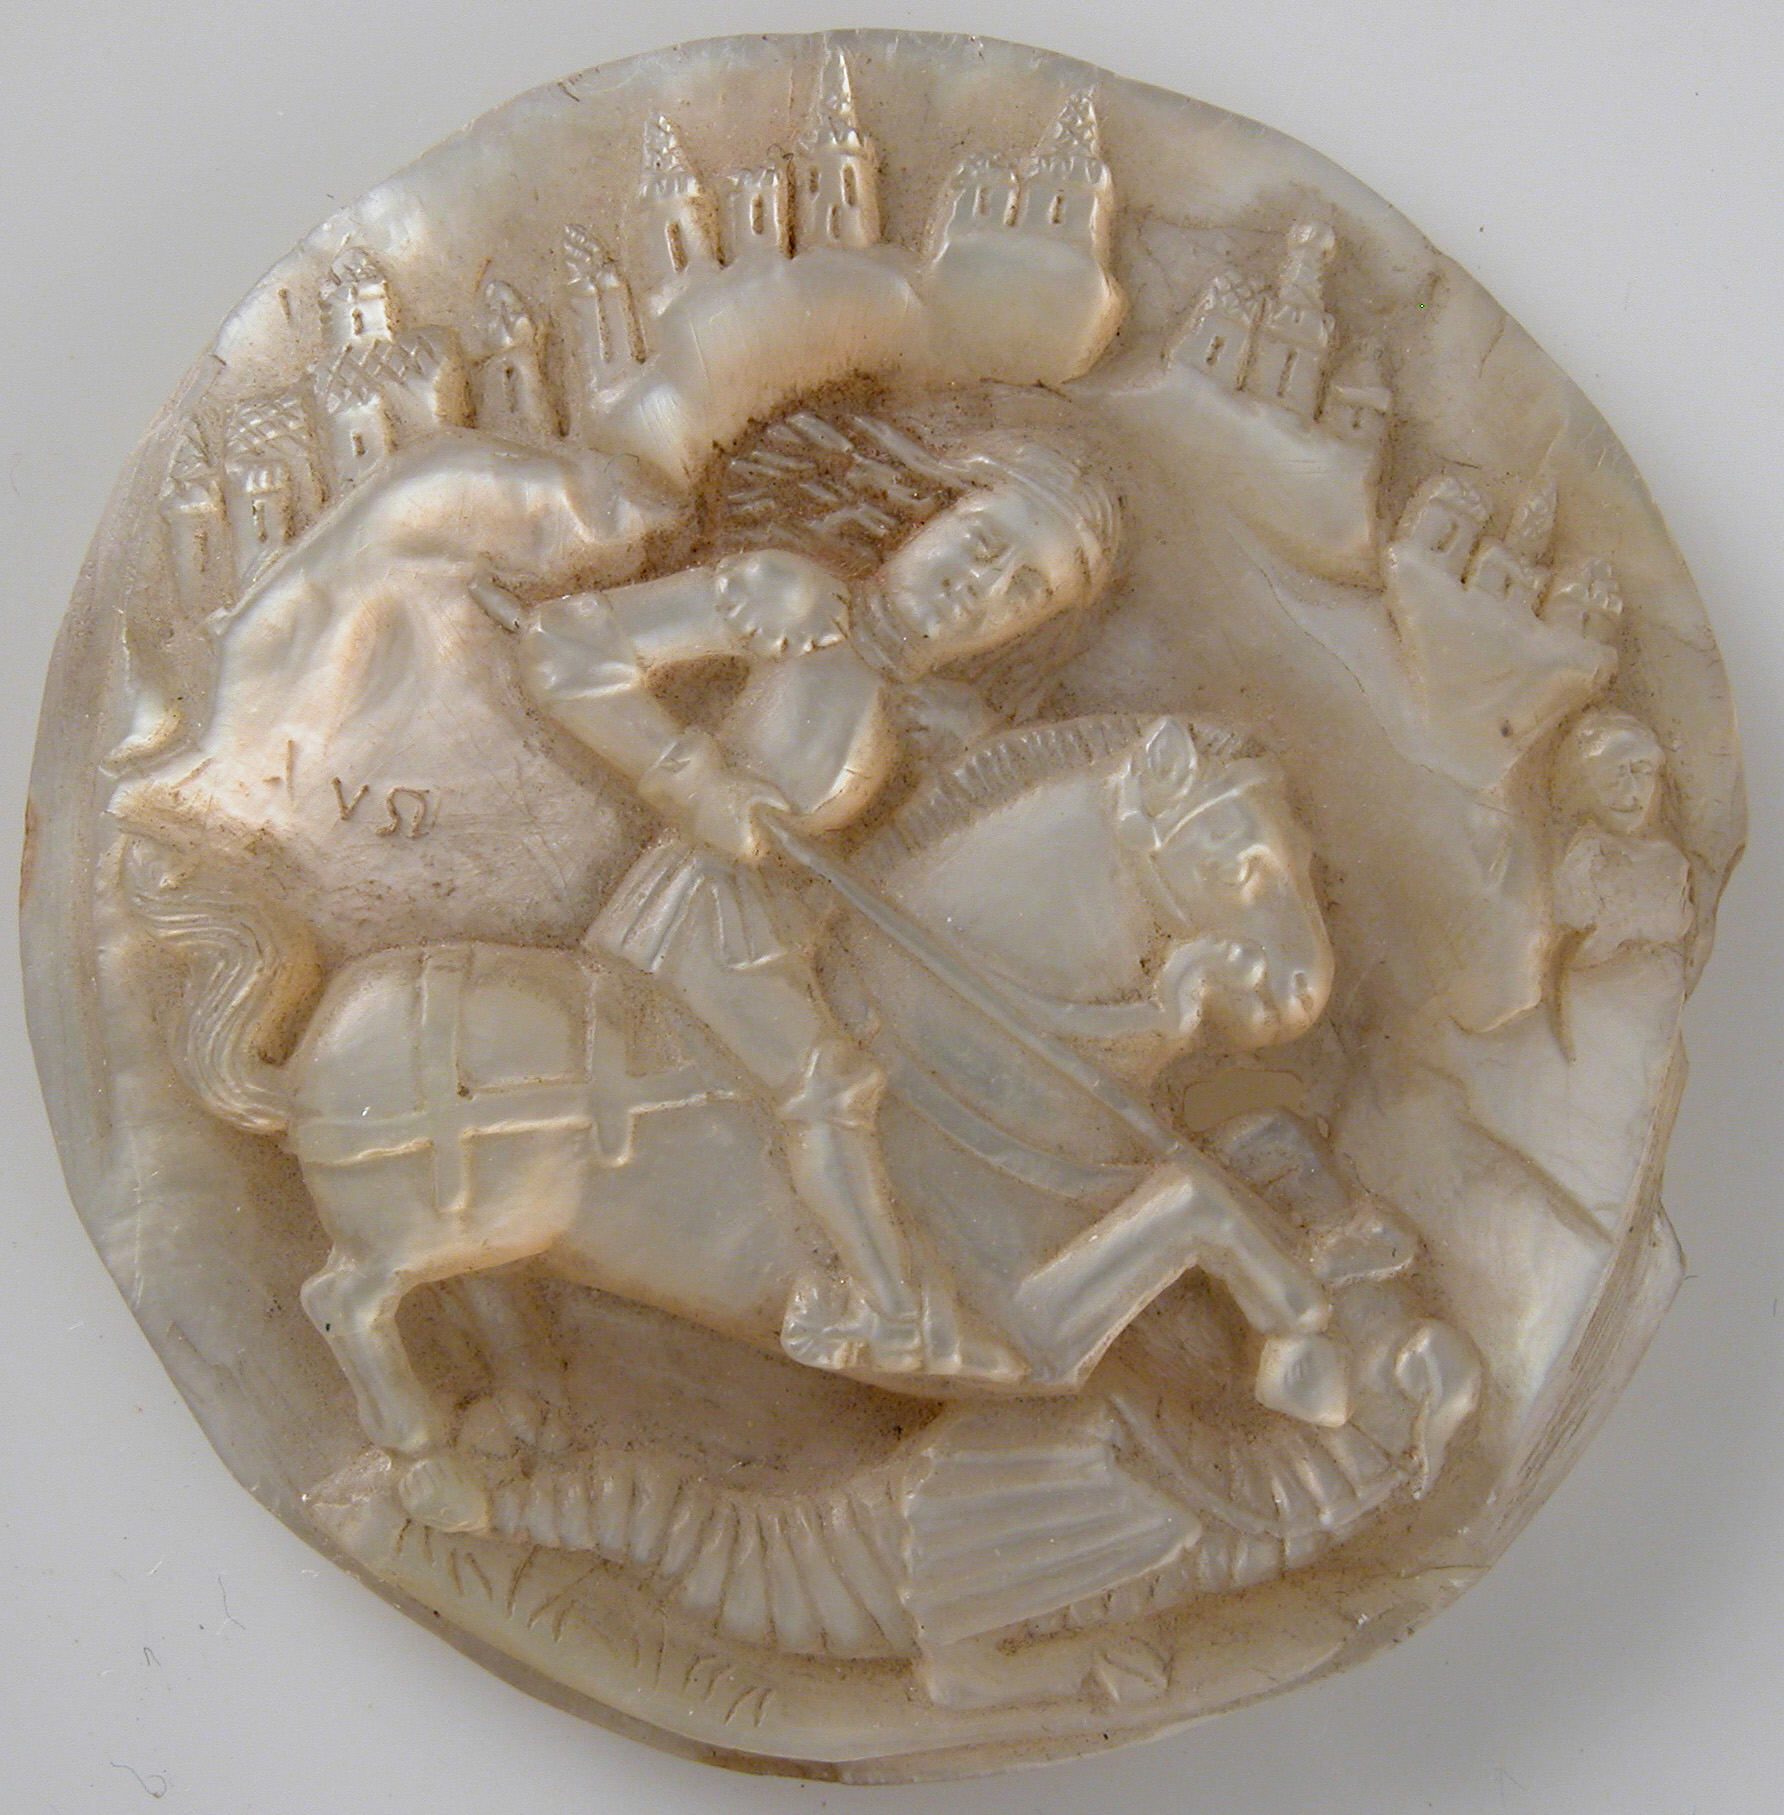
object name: medallion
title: Medallion with Saint George Slaying The Dragon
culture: german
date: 1467-1500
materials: mother of pearl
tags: medallions,dragons,horses